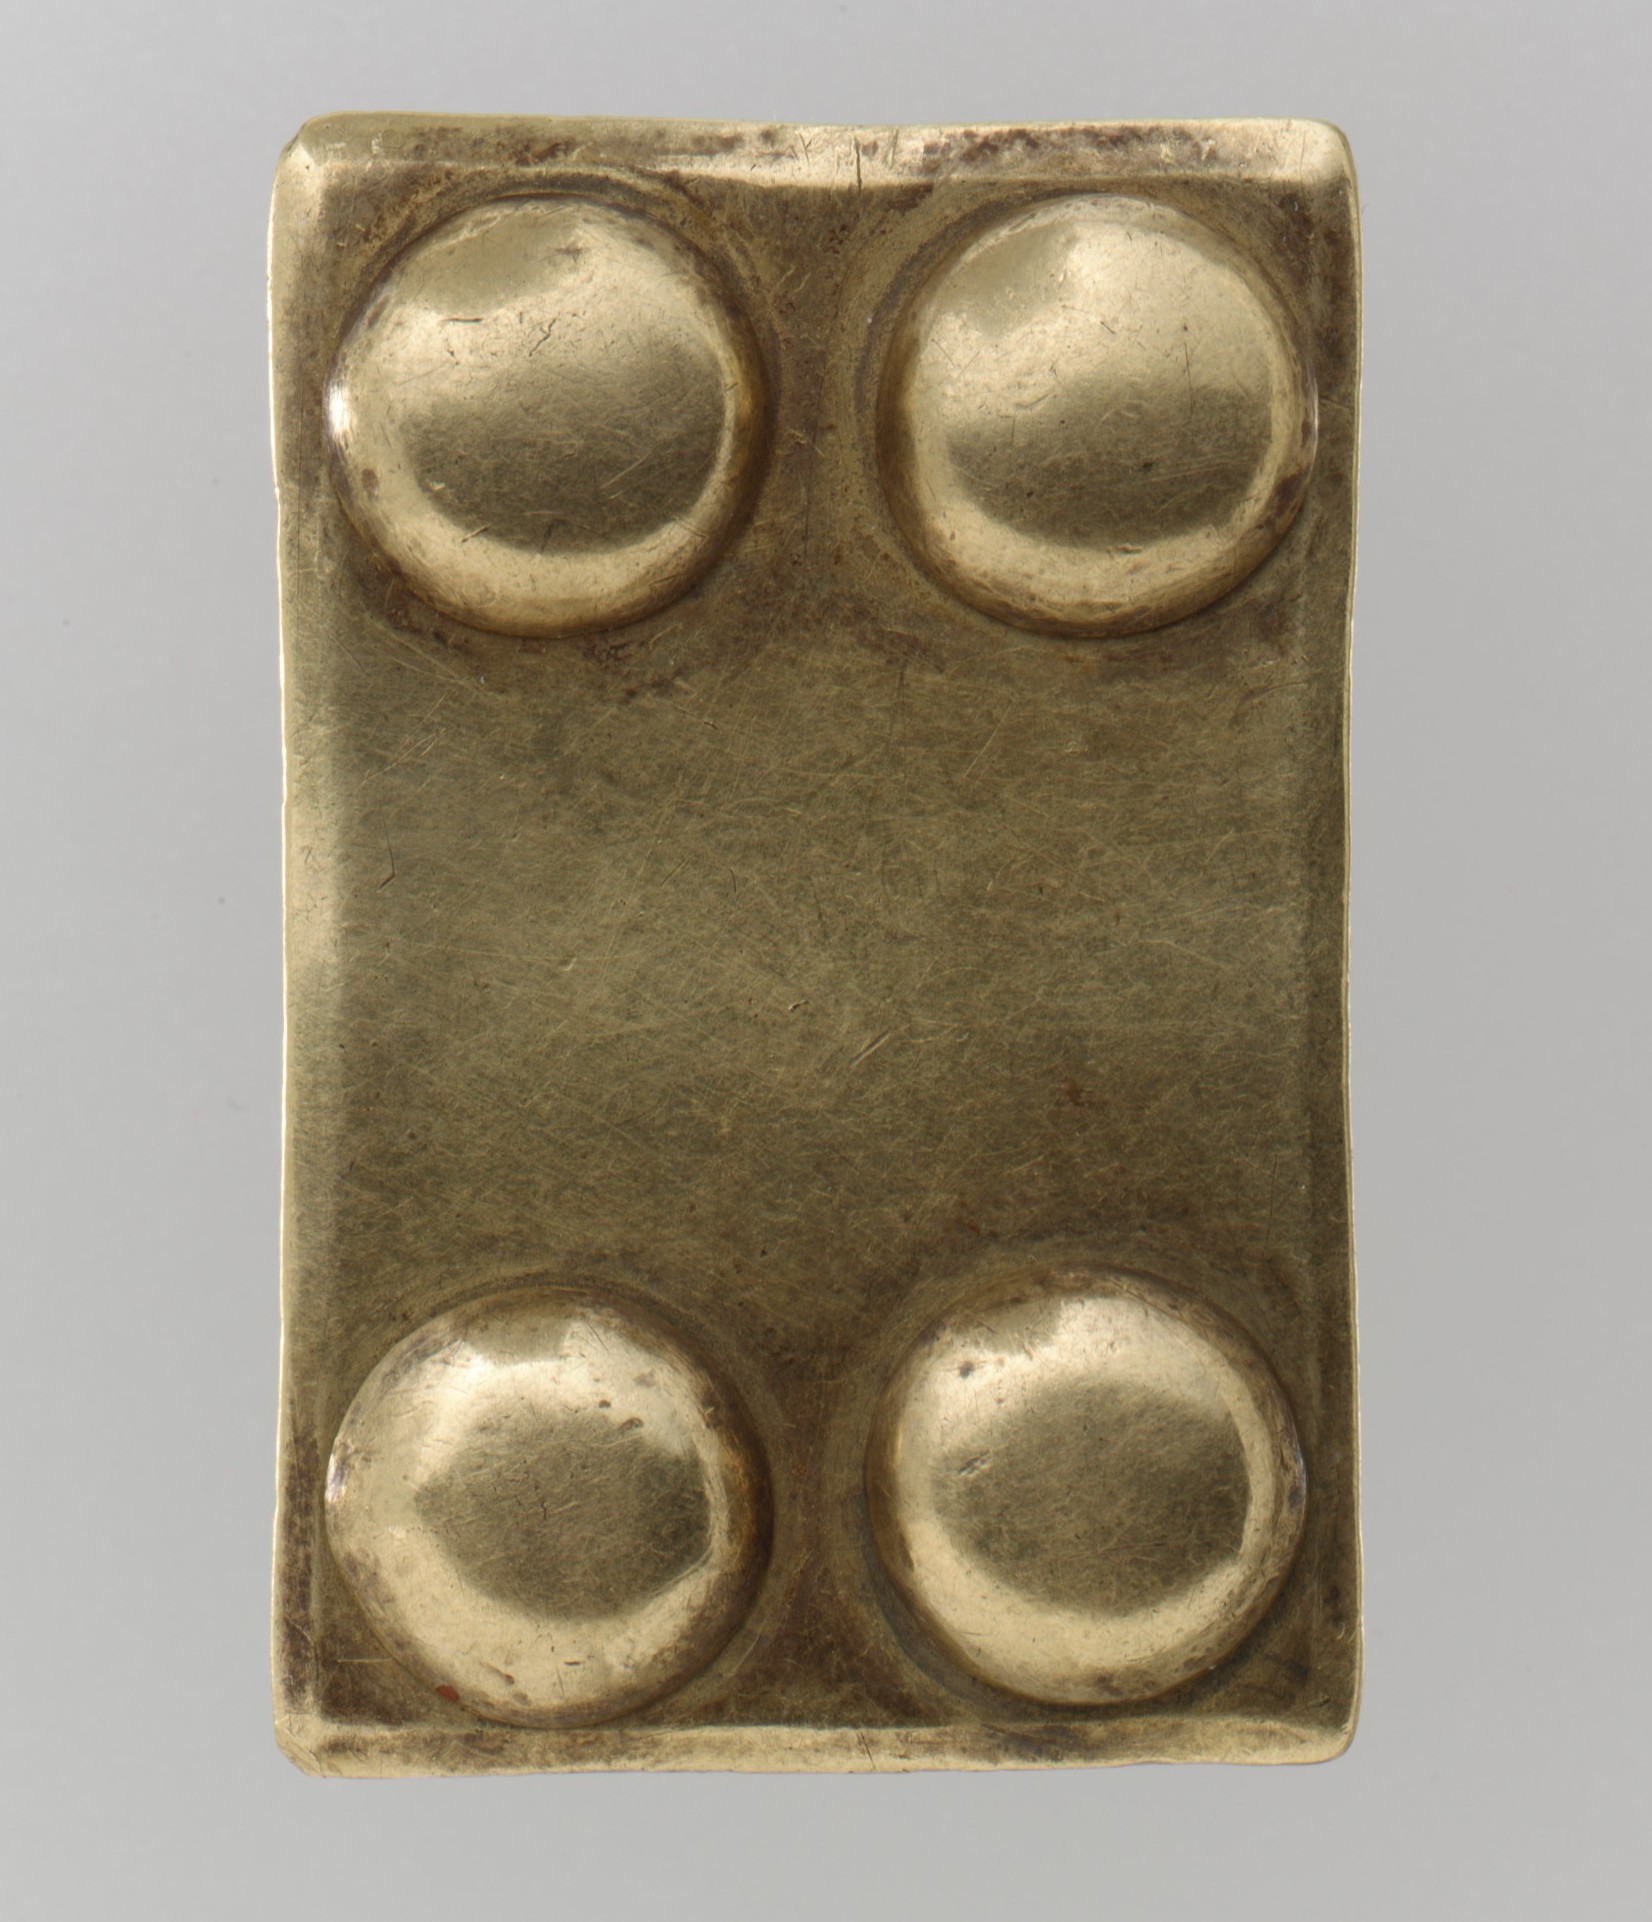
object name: belt mount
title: Gold Belt Mount with Rivets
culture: avar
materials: gold